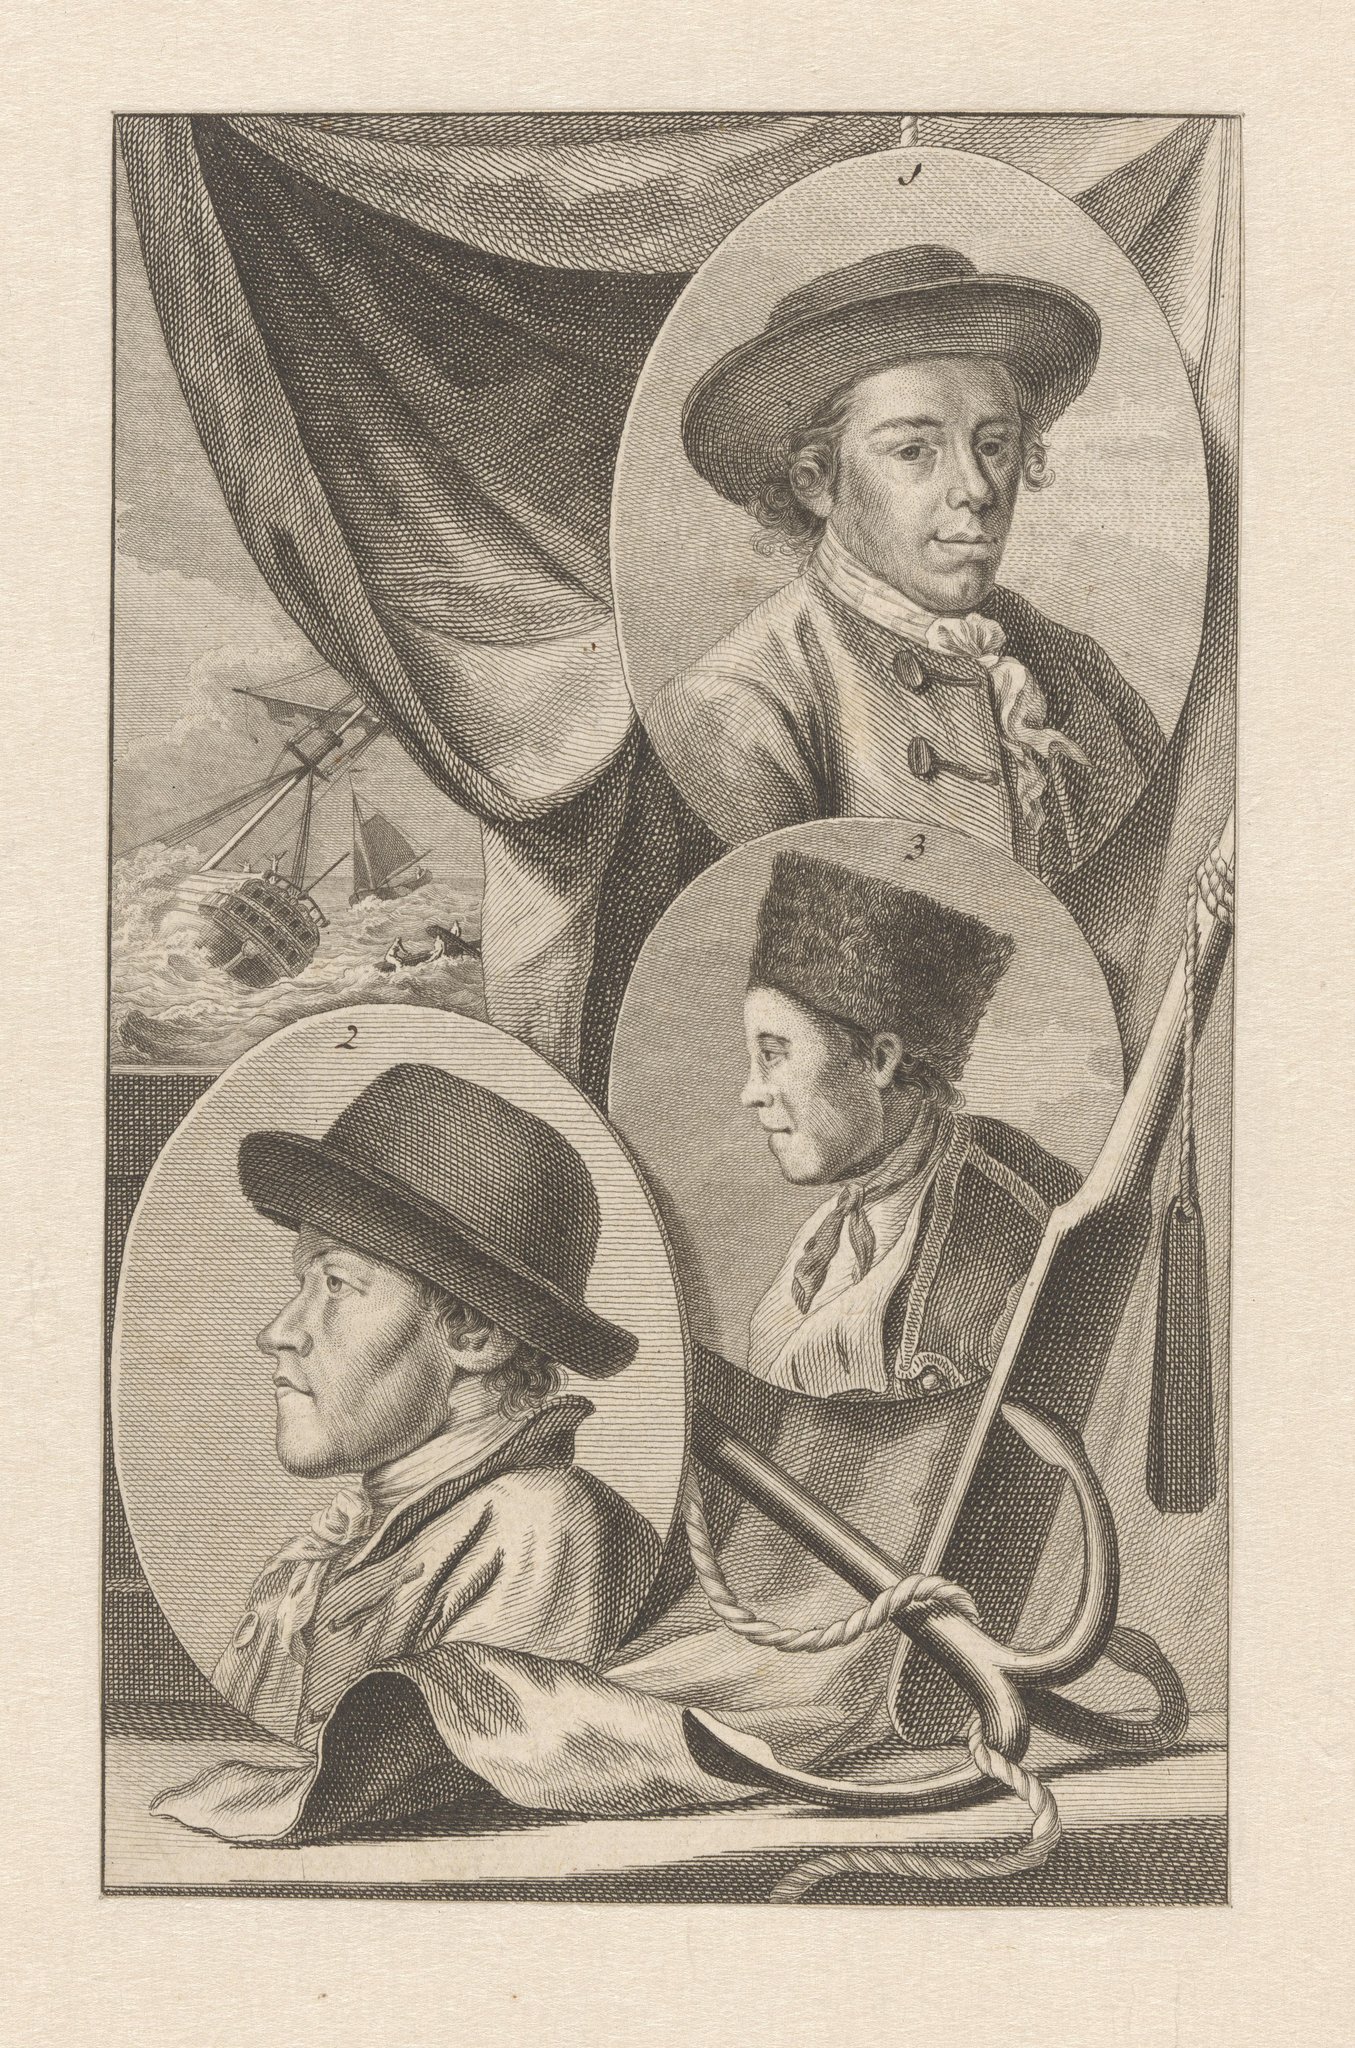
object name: print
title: Portretten van de zeehelden Boussard en de gebroeders Naerebout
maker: Anonymous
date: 1780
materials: paper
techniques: engraving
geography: dordrecht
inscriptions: inscription: ‘J. Snelle’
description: Illustratie in 'Handleiding tot de physionomiekunde', 2 delen, Dordrecht 1780.